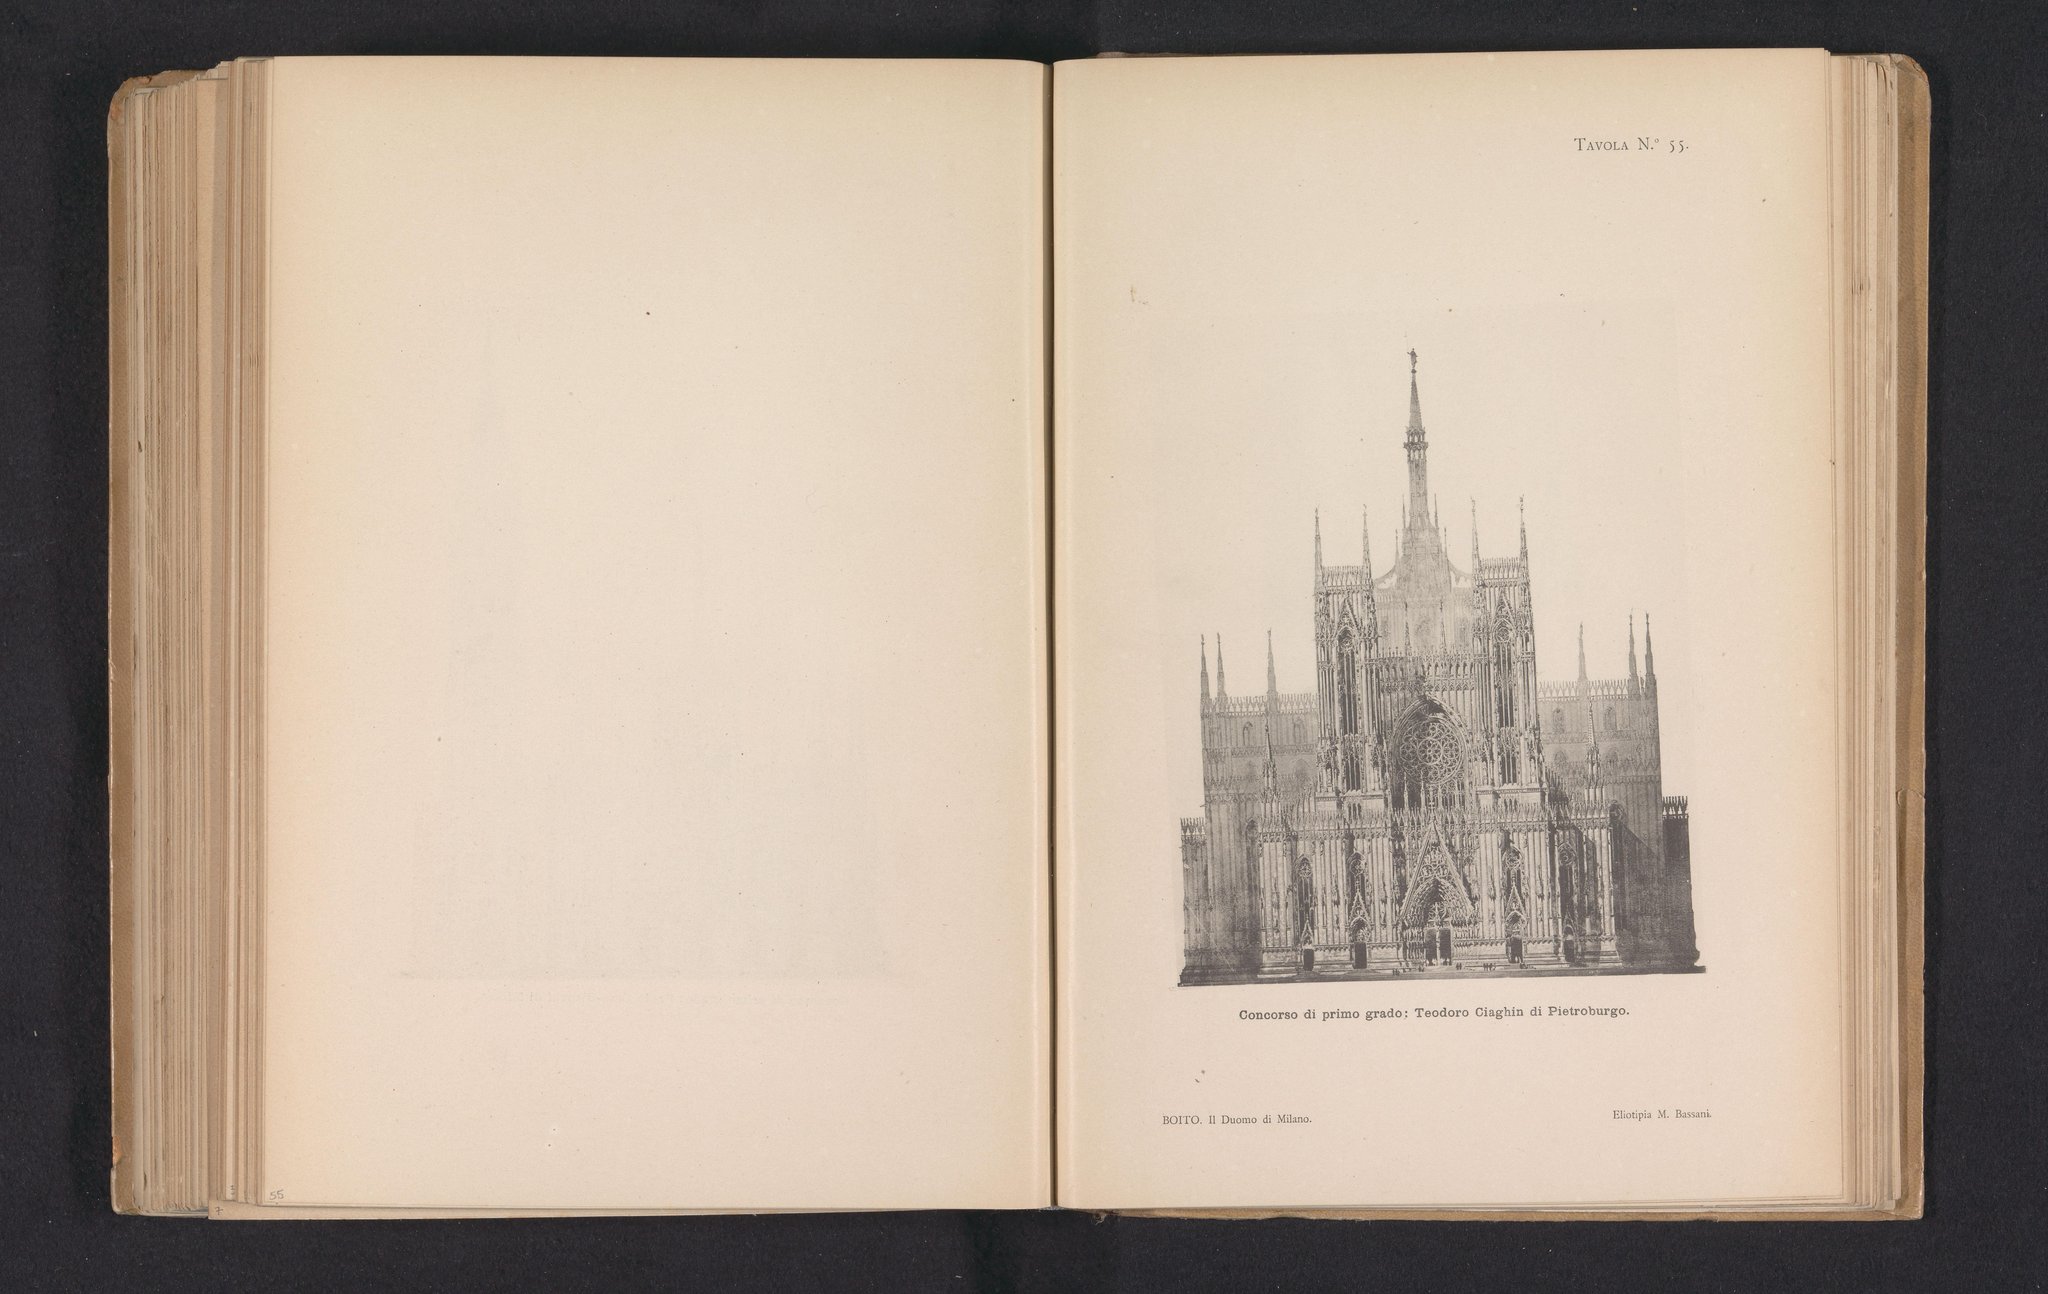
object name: page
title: Fotoreproductie van een ontwerptekening voor de façade van de Dom van Milaan door Teodoro Ciaghin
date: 1886-1889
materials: paper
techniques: photograph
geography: milan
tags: drawing, sketch, parts of church exterior and annexes: façade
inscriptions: number: ‘Tavola No. 55.’